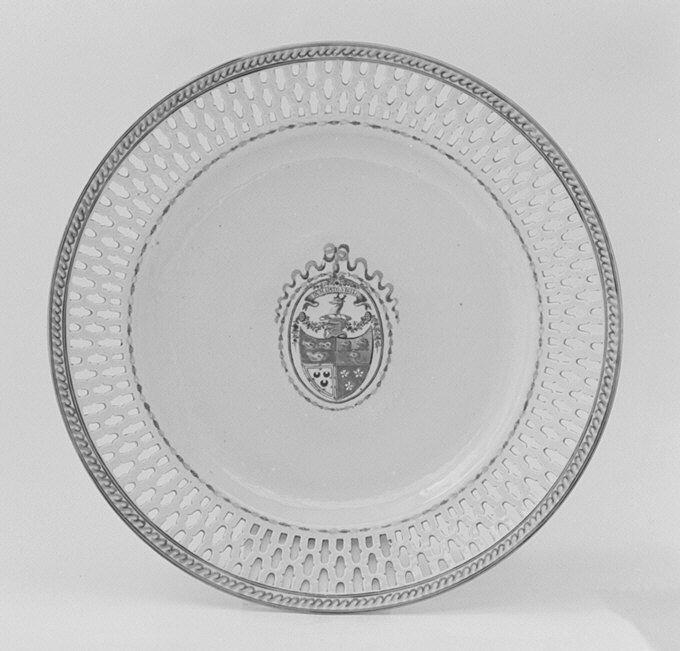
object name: plate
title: Plate (part of a service)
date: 1770-1785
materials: hard paste porcelain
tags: coat of arms